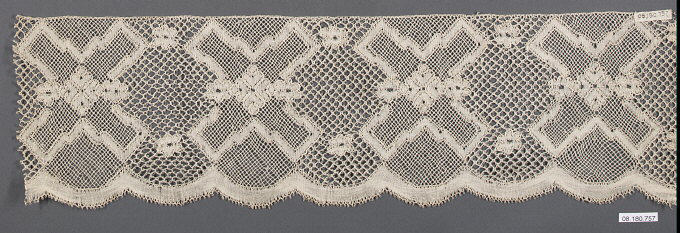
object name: fragment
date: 1801-1900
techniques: lace